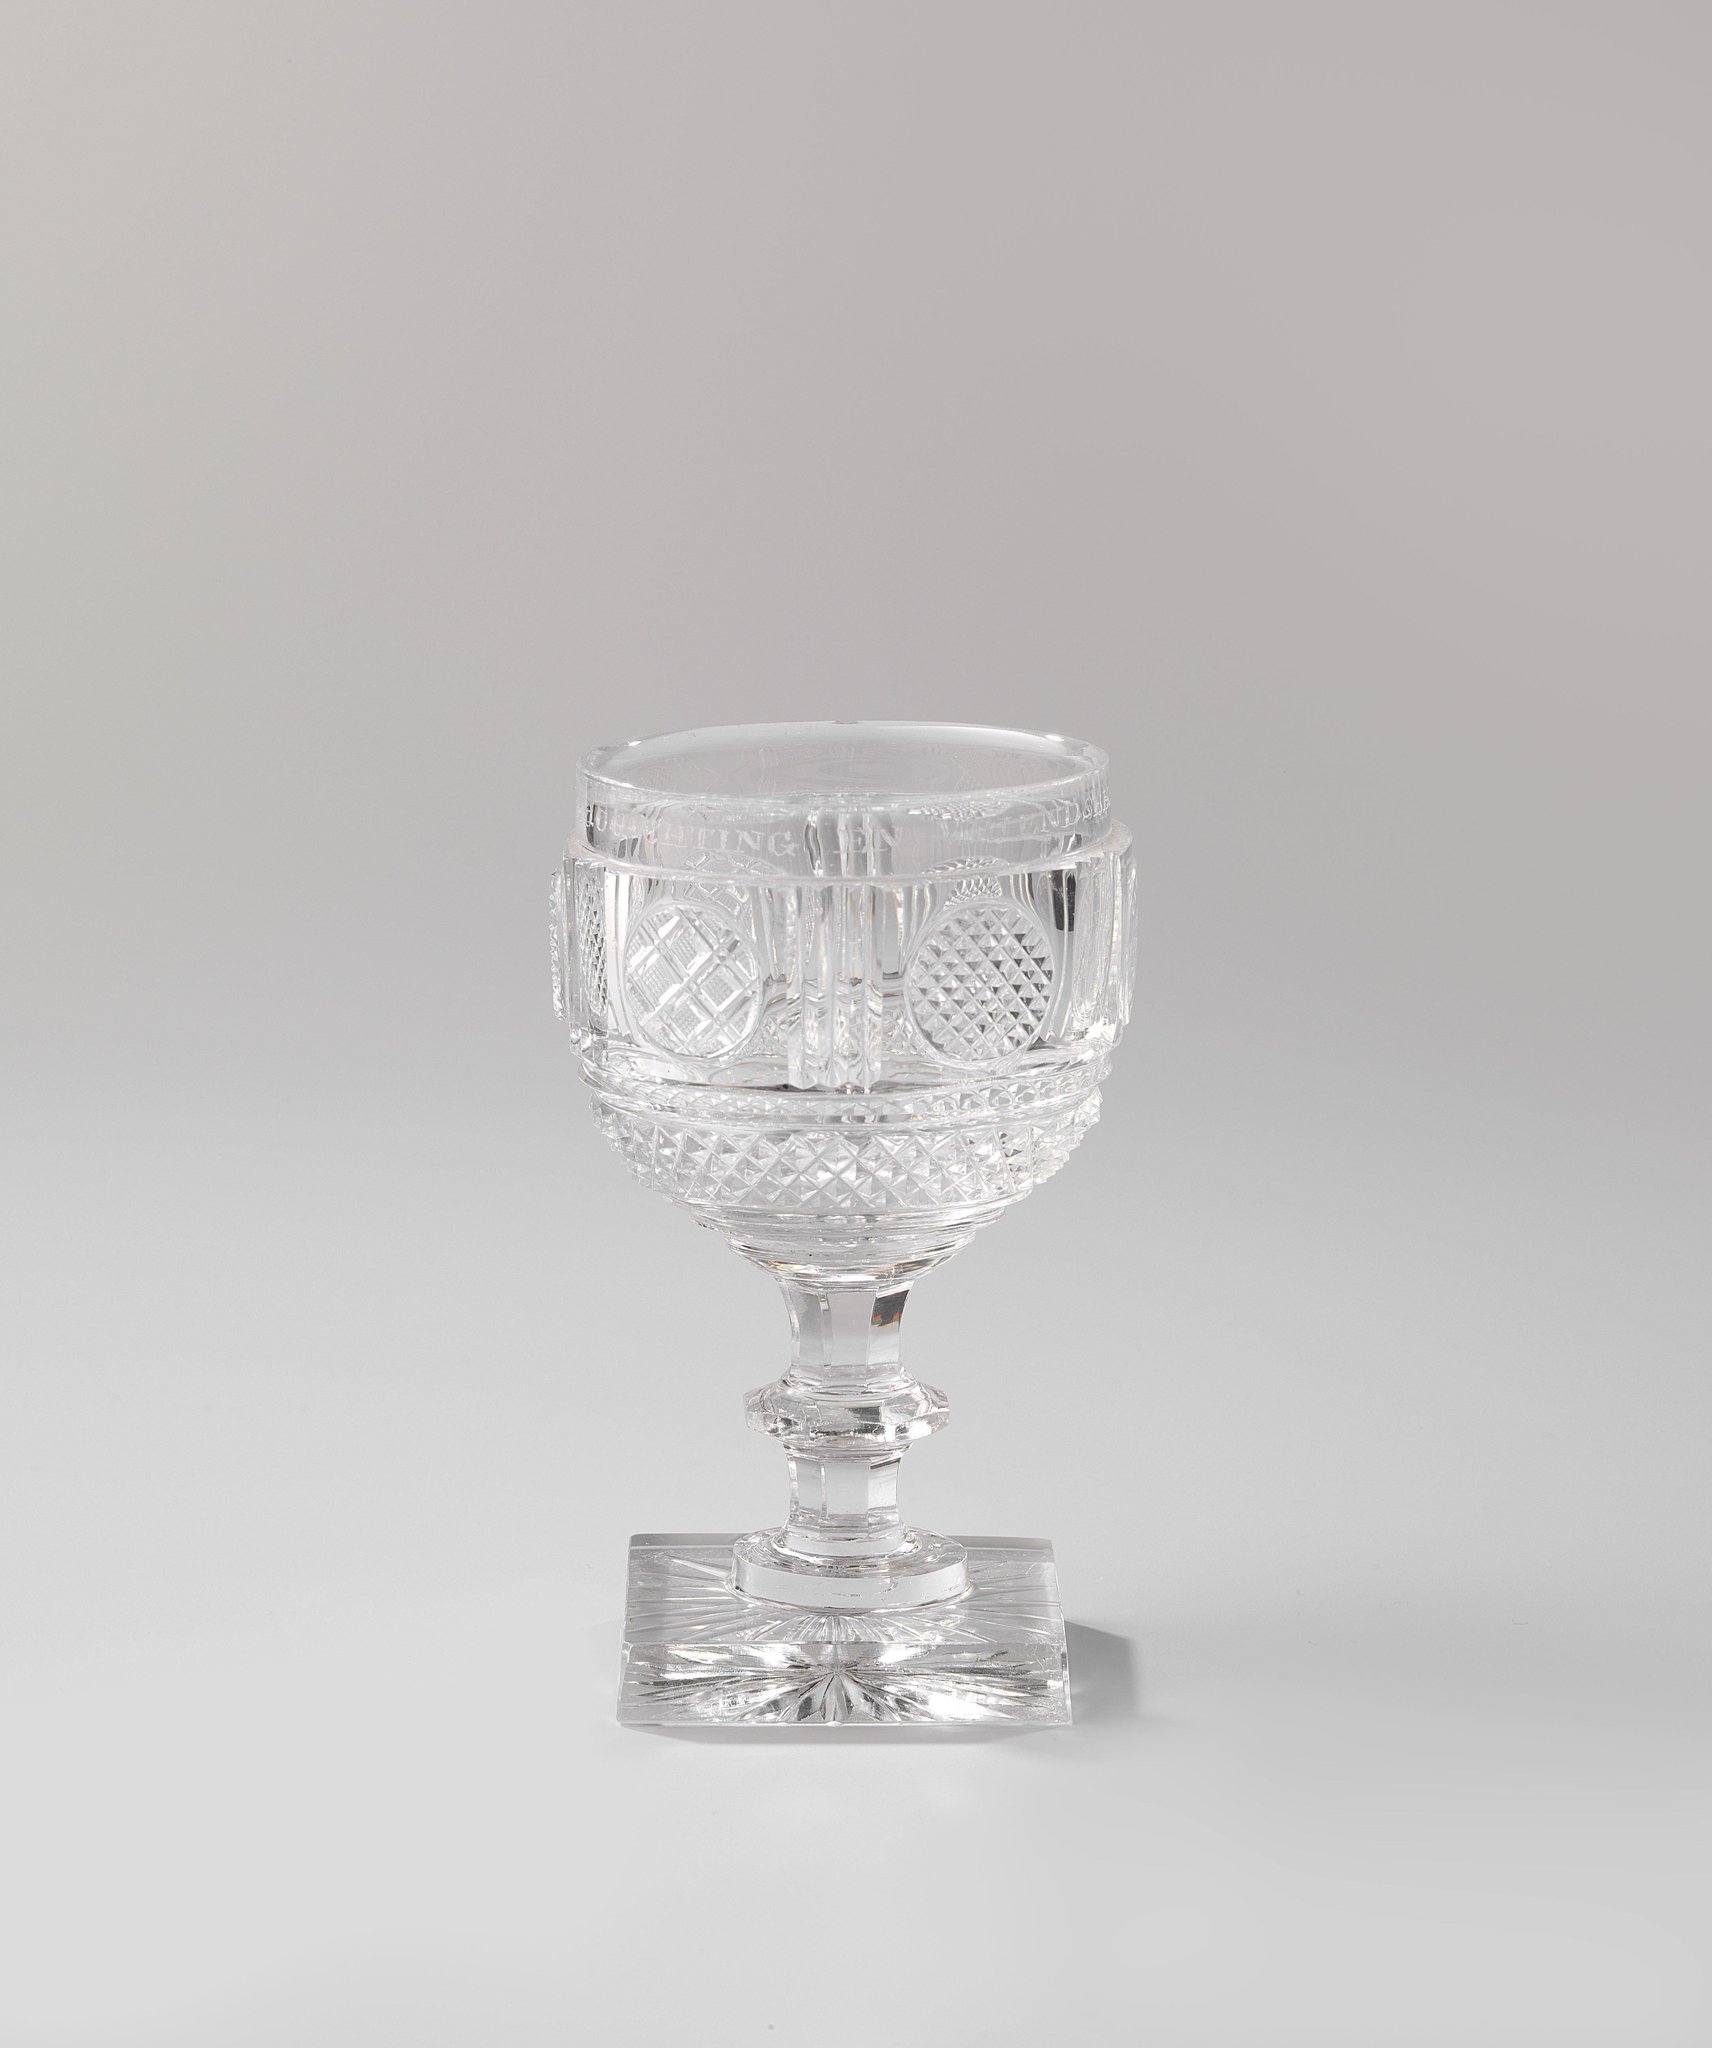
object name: goblet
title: Kelkglas op vierkante voet, met het opschrift: CITADEL ANTW. 1830 & 1831 H J v Mourik 2 Lt Kwartm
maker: Anonymous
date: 1831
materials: glass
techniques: diamond point engraving, glassblowing, grinding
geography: low countries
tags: citadel van antwerpen (19e eeuw), strijd om de citadel van antwerpen (1832), belgische revolutie